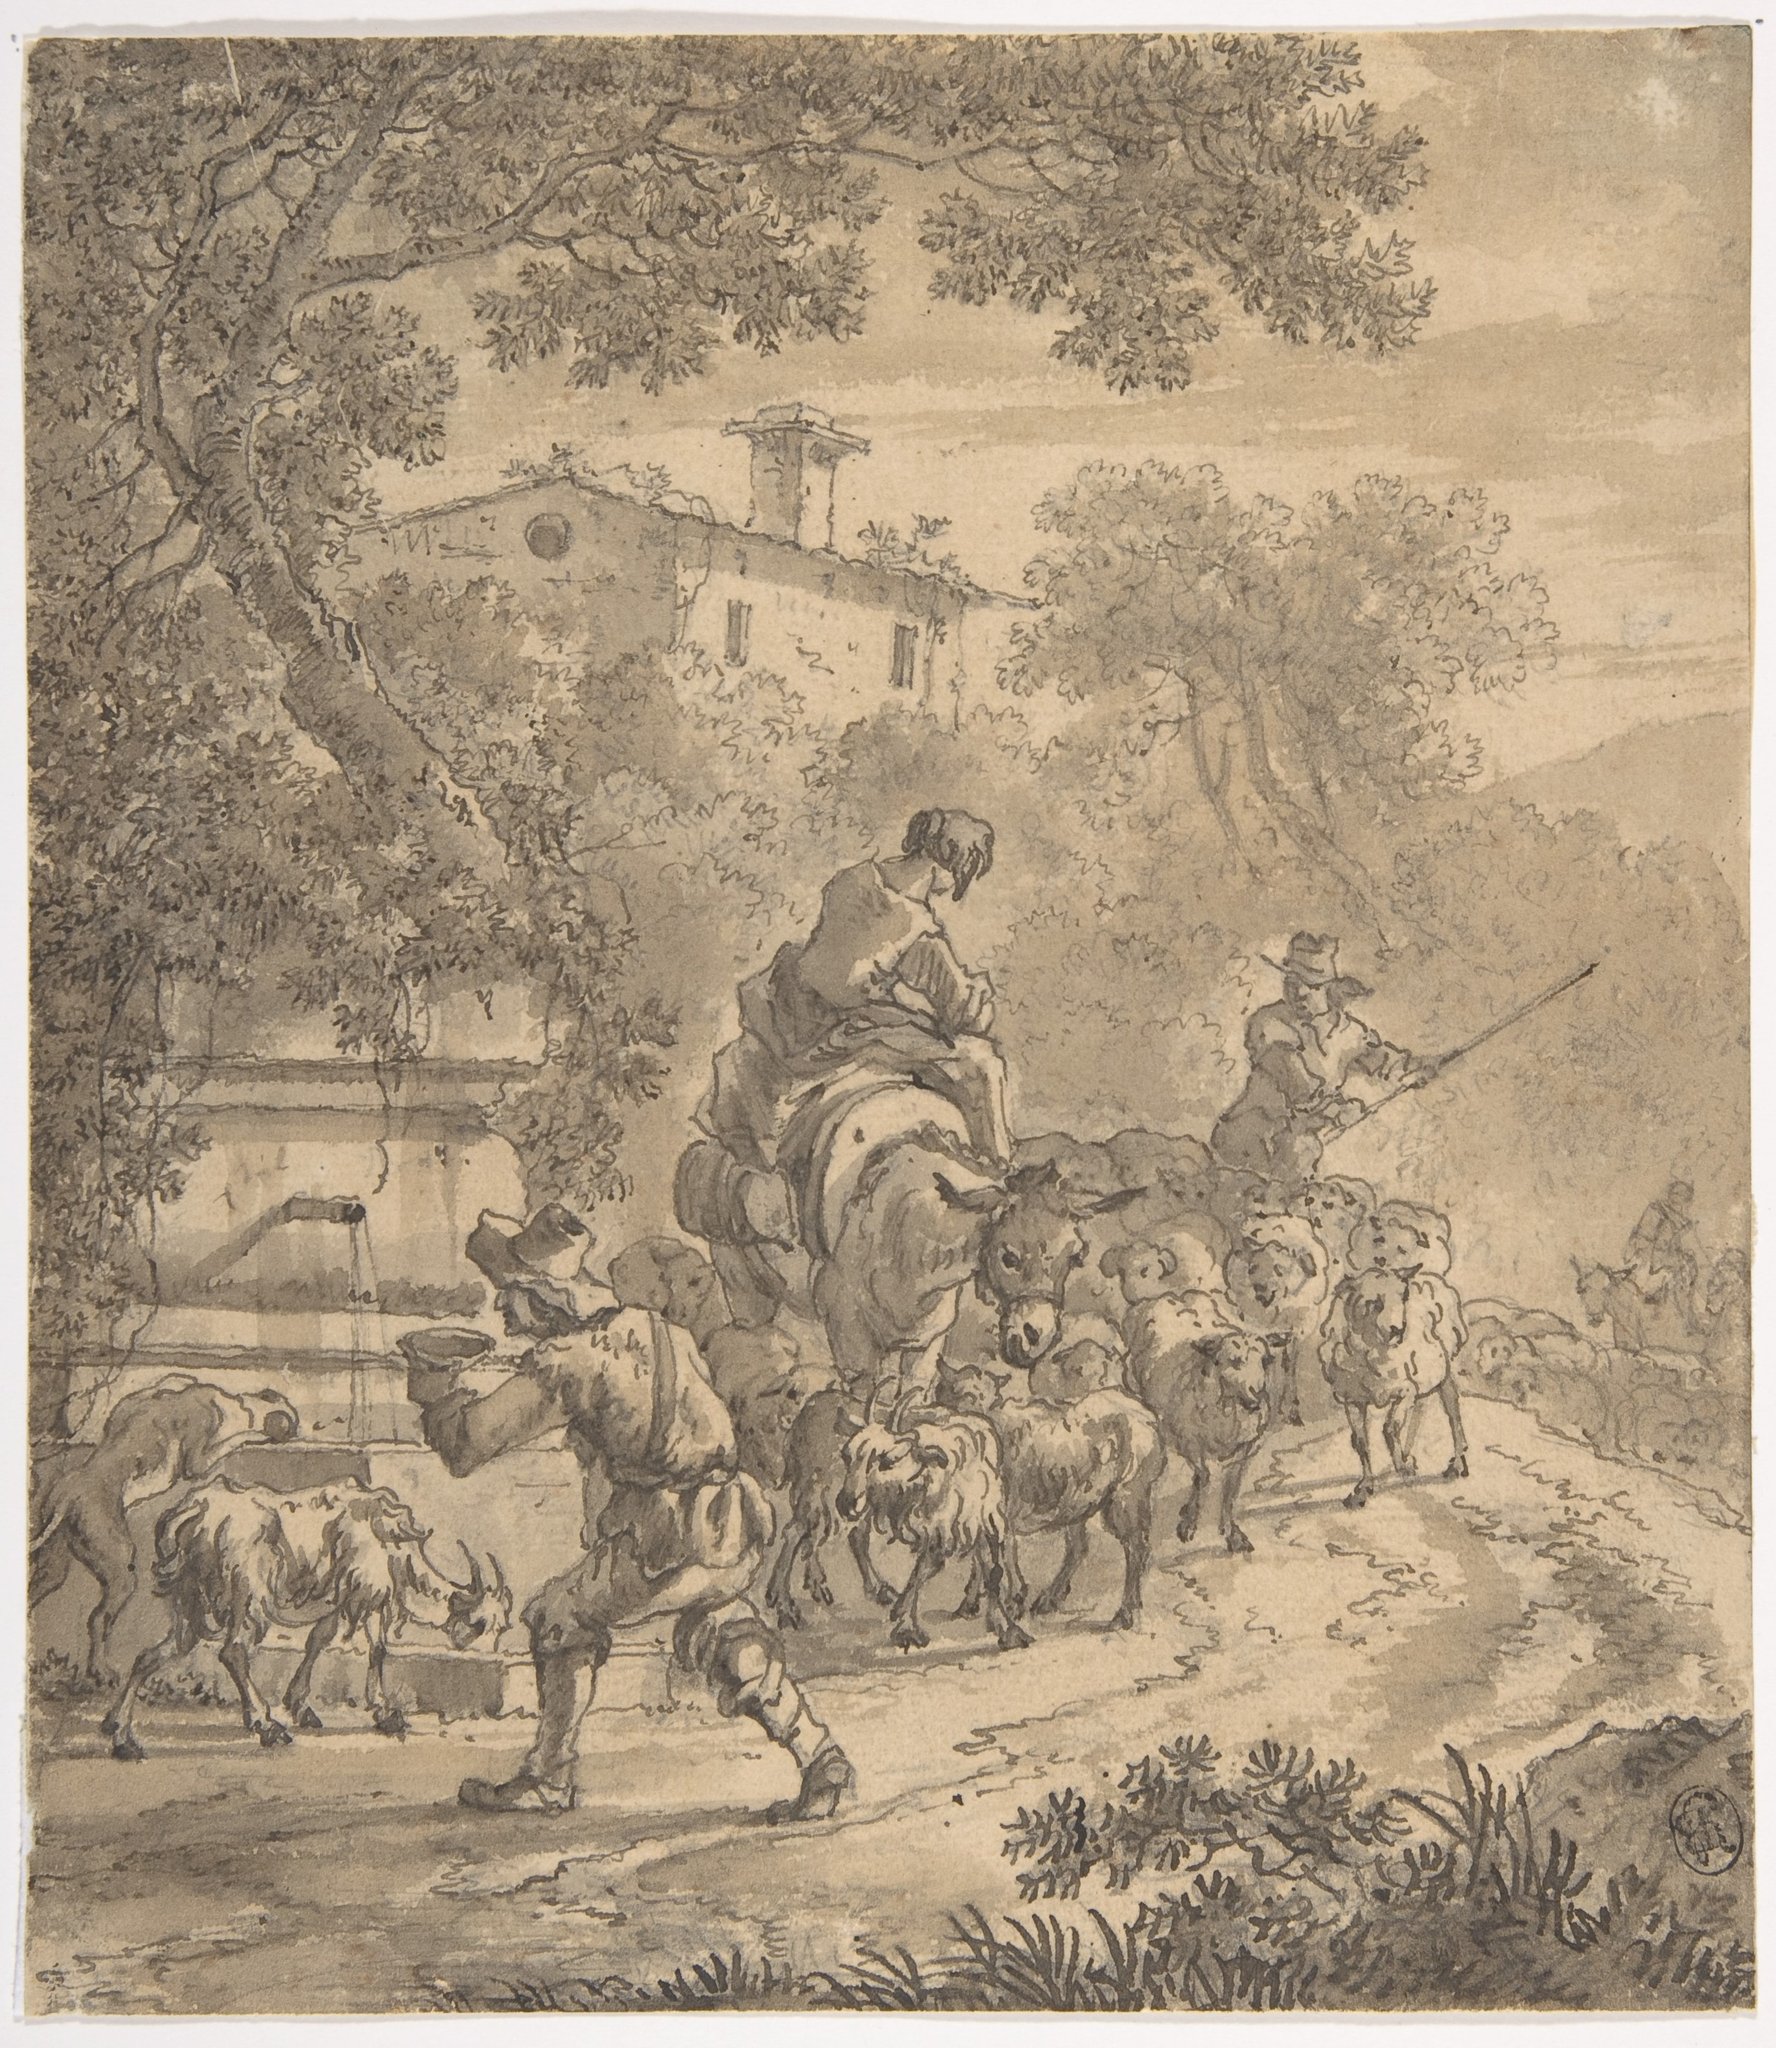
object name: drawing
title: Landscape with Shepherds and their Flock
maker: adriaen van der cabel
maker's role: artist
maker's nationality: dutch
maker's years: 1631-1705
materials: graphite, ink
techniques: pen, wash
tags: sheep,landscapes,trees,shepherds